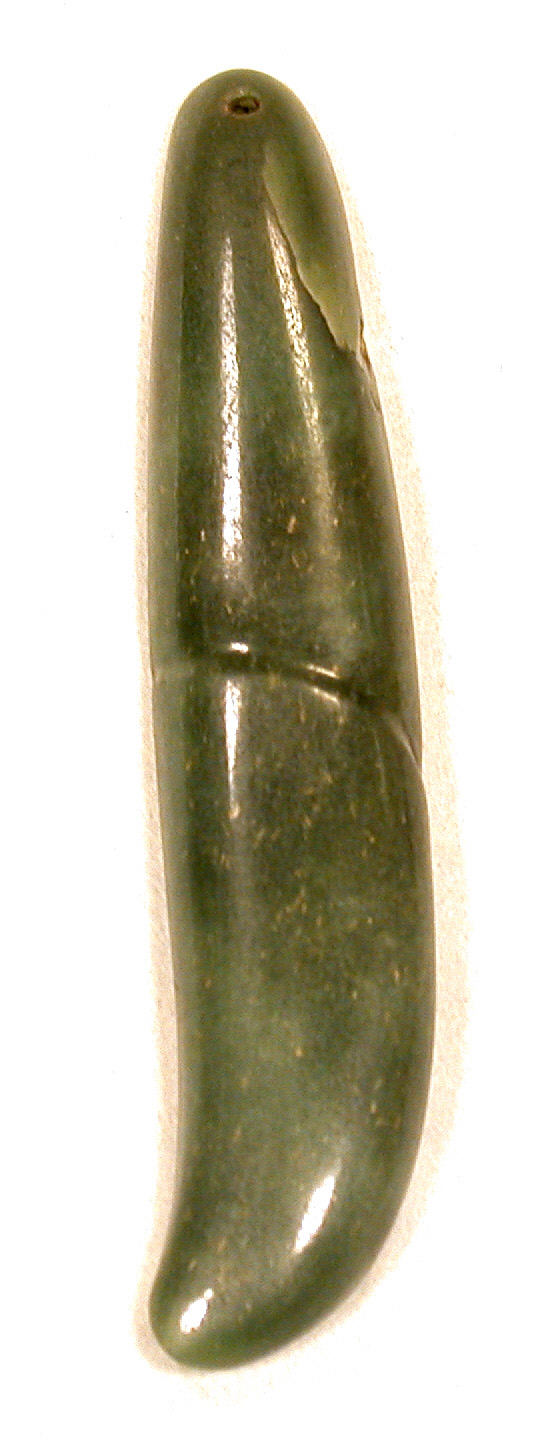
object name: pendant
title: Tooth-Form Pendant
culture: olmec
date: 1000-301 BCE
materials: jade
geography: mexico